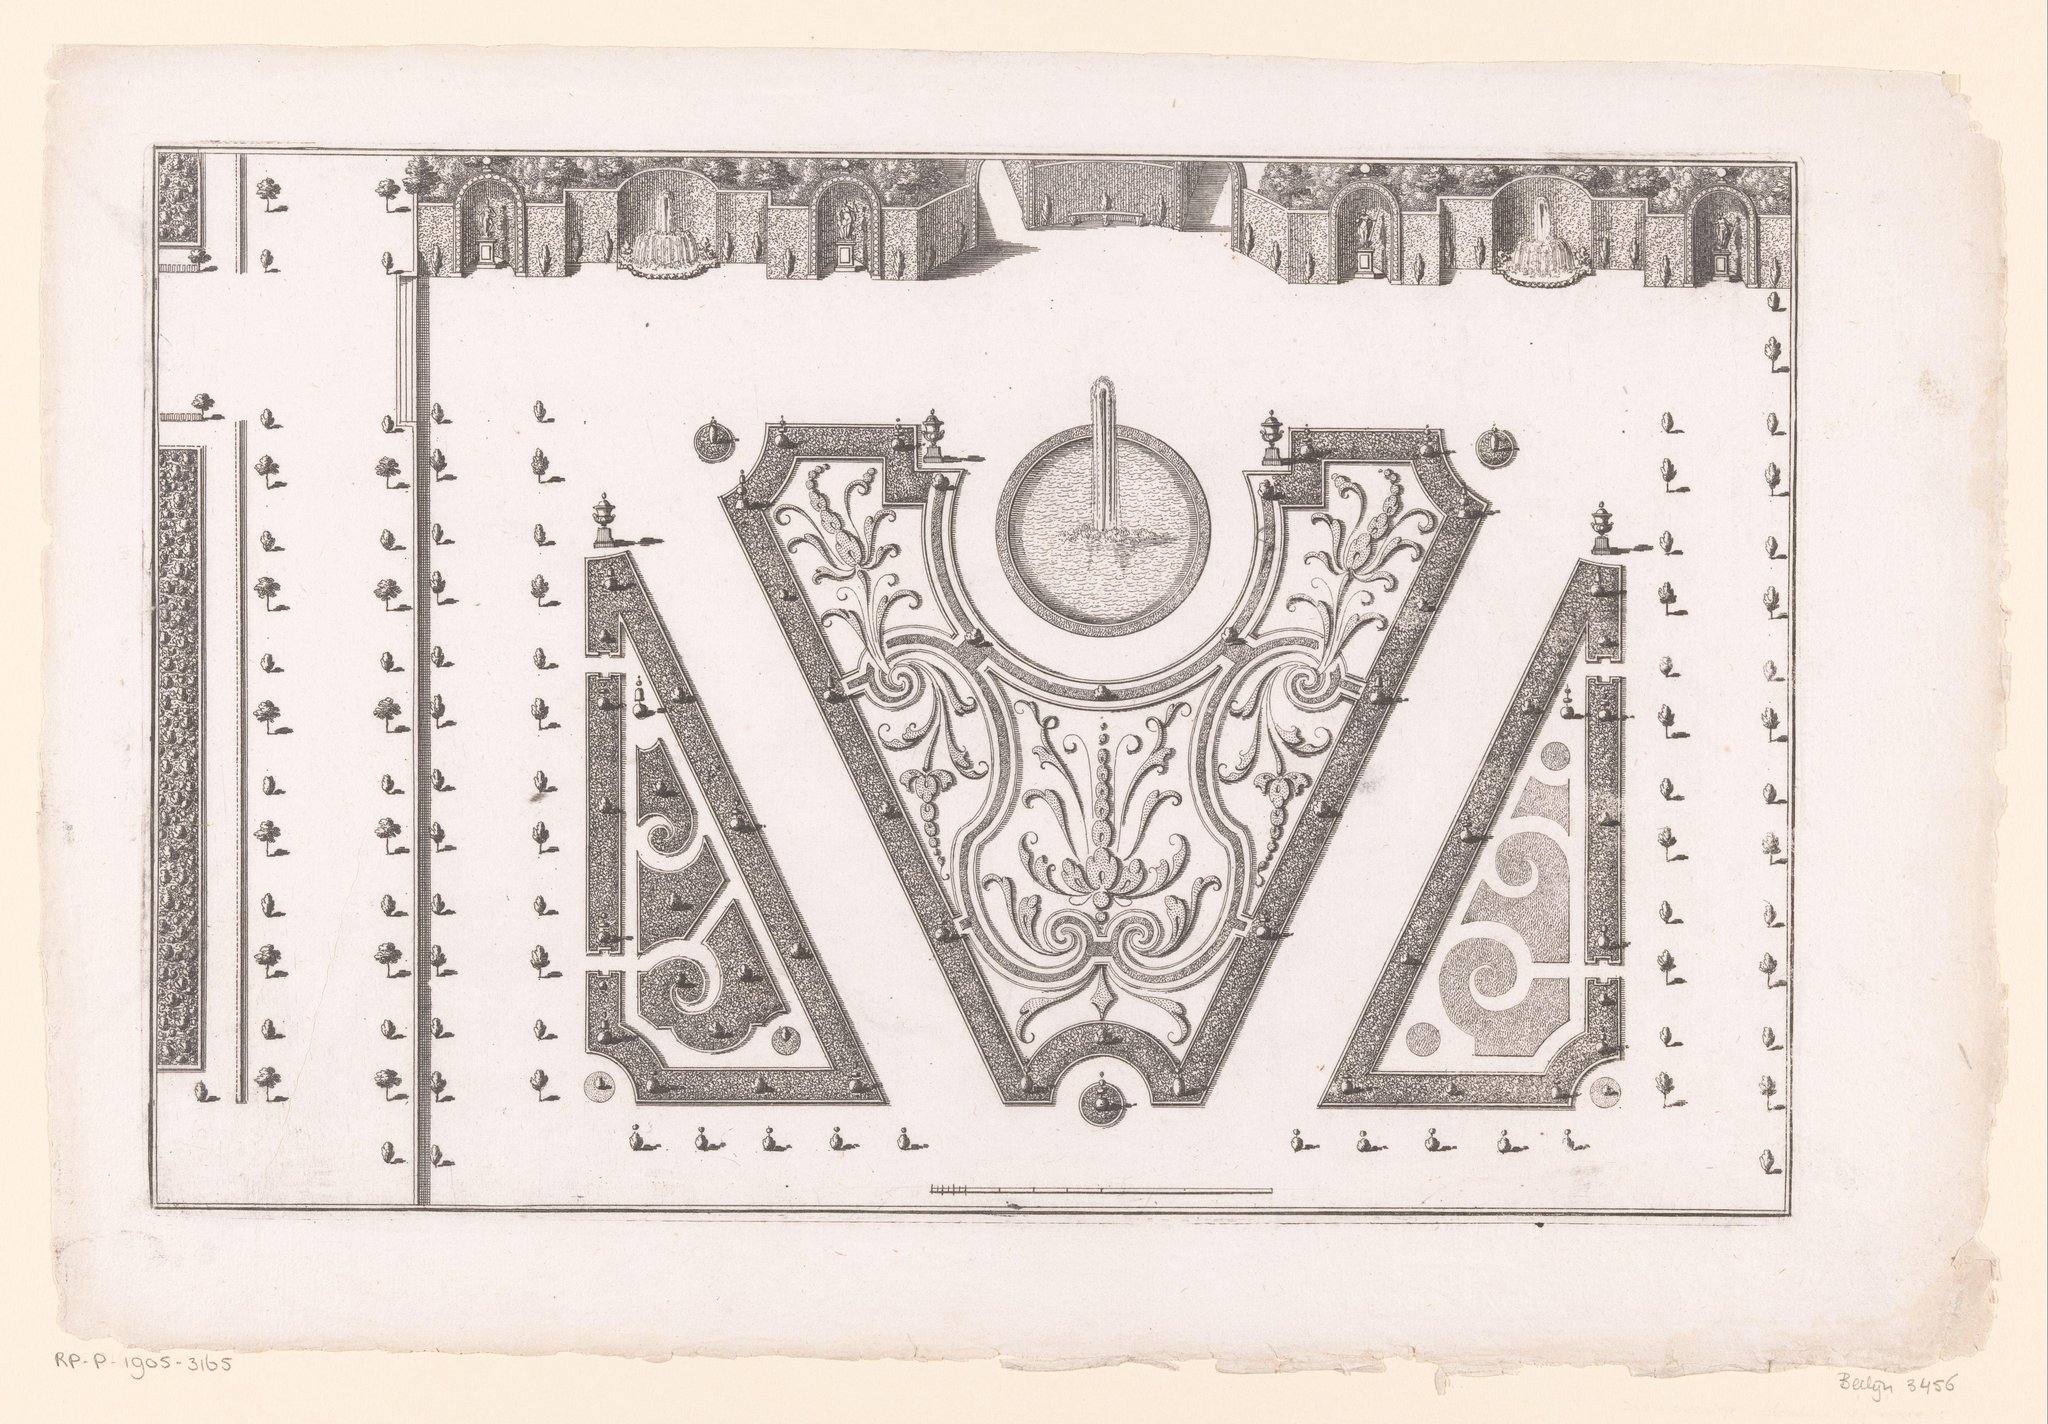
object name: print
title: Plattegrond van tuin met driehoekige parterres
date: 1650-1700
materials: paper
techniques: etching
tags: plan, map of garden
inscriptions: collector's mark: Lugt 2228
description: Drie driehoekige parterres afgescheiden door paden en daarboven een ronde fontein. Links en rechts bomenlanen. Aan de bovenzijde sluit een haag met fonteinen en sculpturen de tuin af.